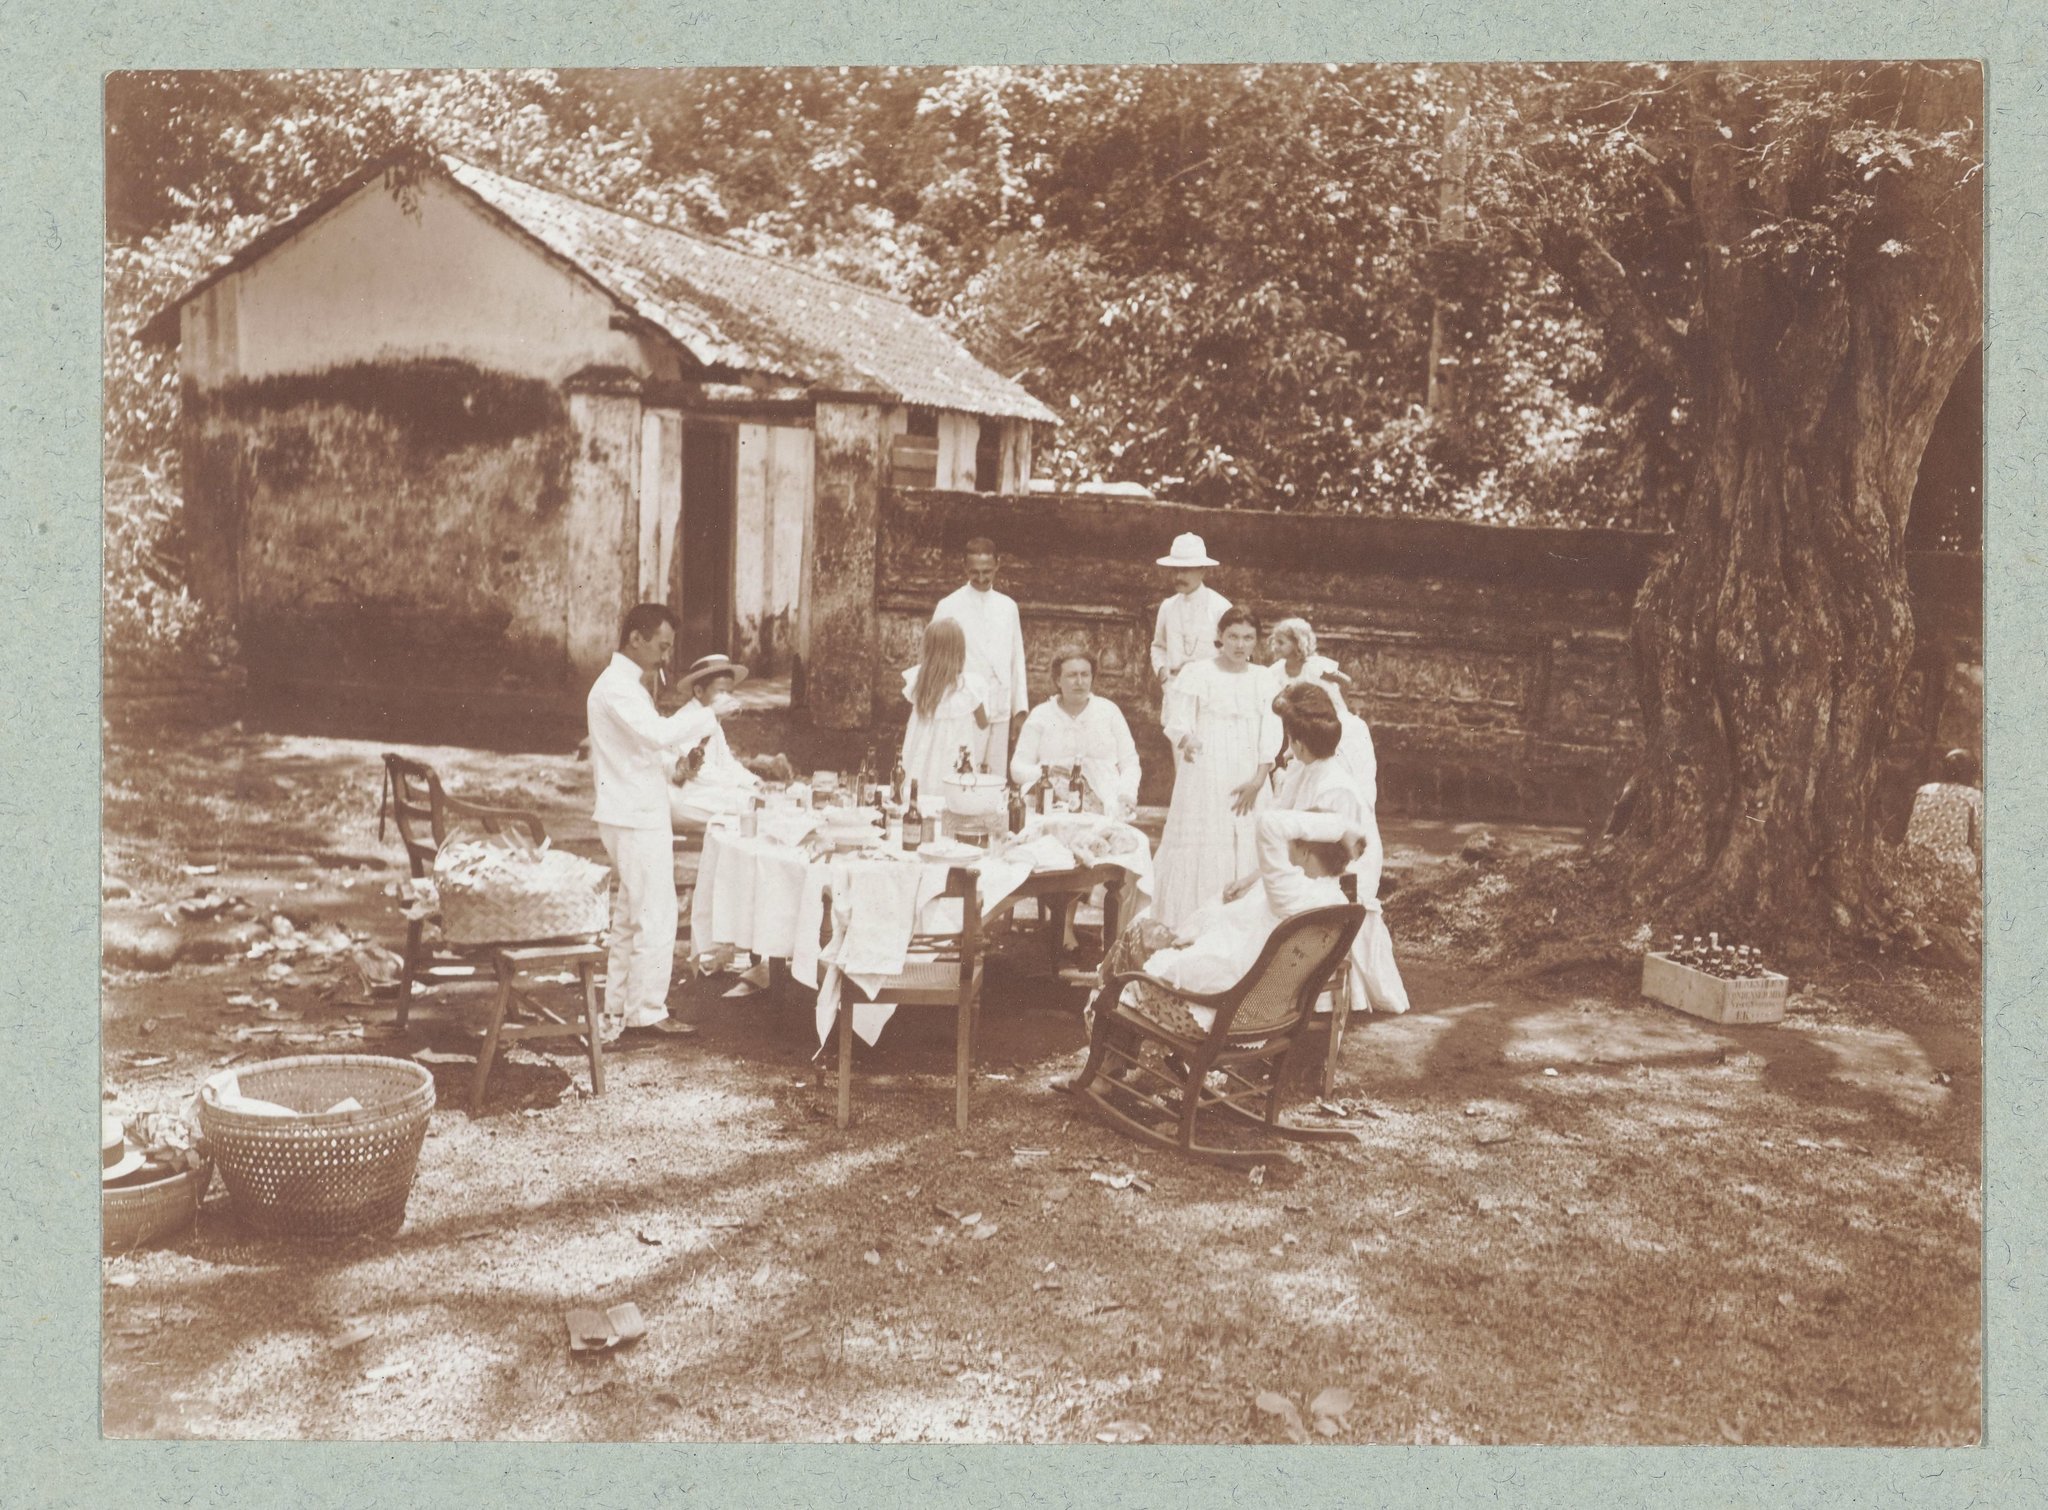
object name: photograph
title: Photographieën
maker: frits freerks fontein fz.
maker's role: fotograaf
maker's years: 1882-1928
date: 1910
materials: cardboard, paper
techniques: gelatin silver print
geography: netherlands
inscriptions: caption: ‘Batoewan bij Soemenep 1910’